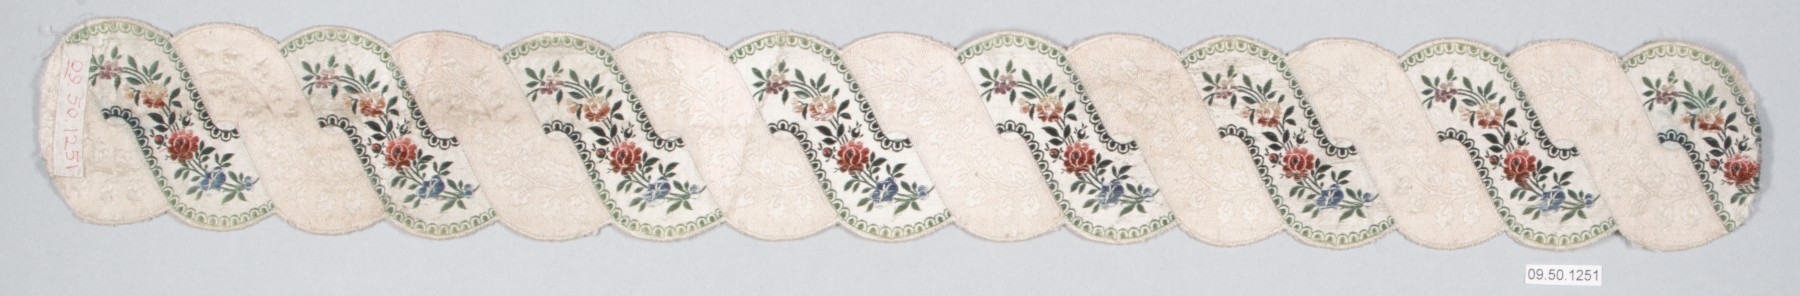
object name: ribbon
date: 1701-1800